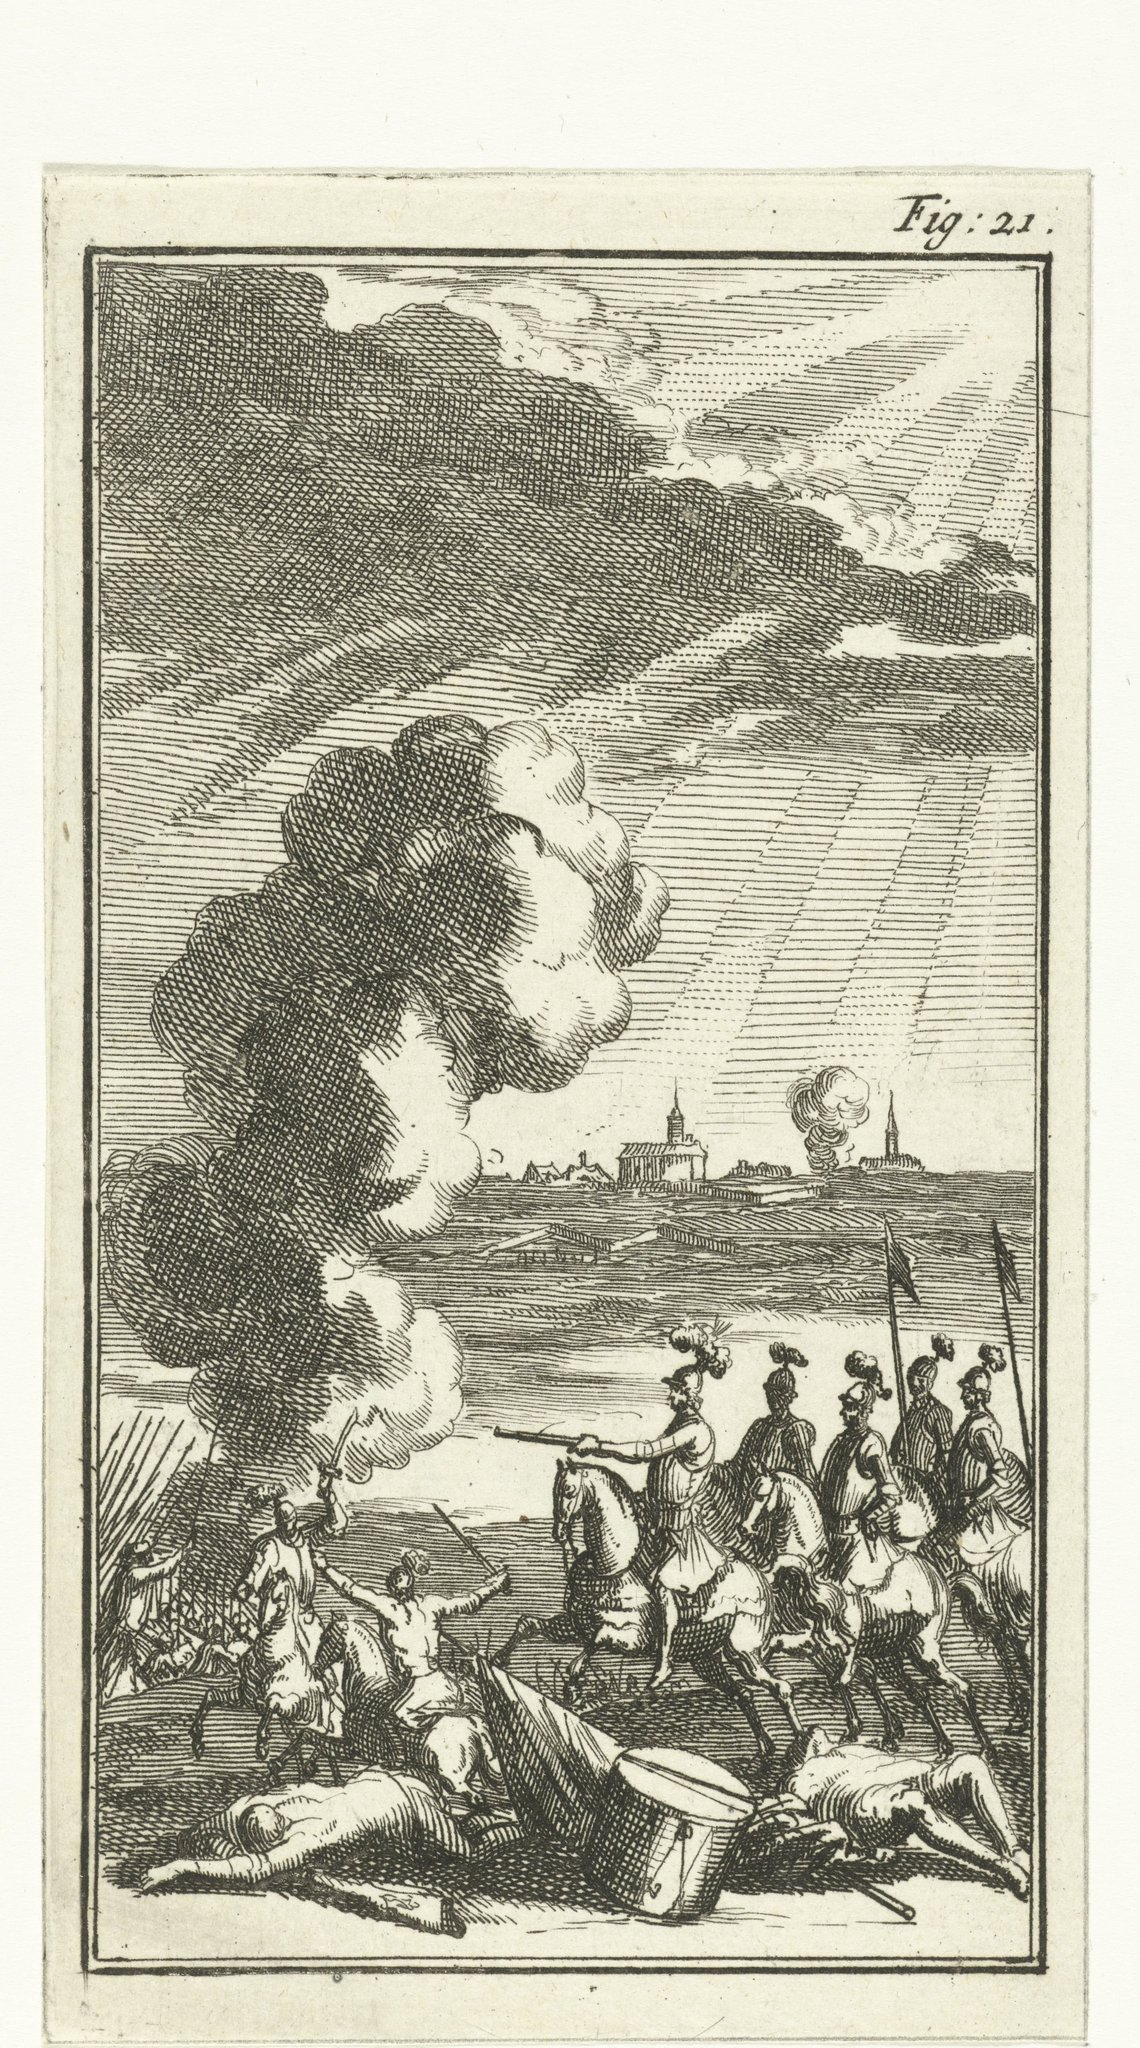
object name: print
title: Beleg van 's Hertogenbosch, 1629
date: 1691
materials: paper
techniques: etching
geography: amsterdam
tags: siege, position war, den bosch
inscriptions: collector's mark: Lugt 2228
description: Illustratie uit: Beeck, Barent. Le triomphe royal, où l'on voit dêscrits les arcs de triomphe (...) erigez à la Haye, à l'honneur de Guillaume III. Den Haag, 1691.